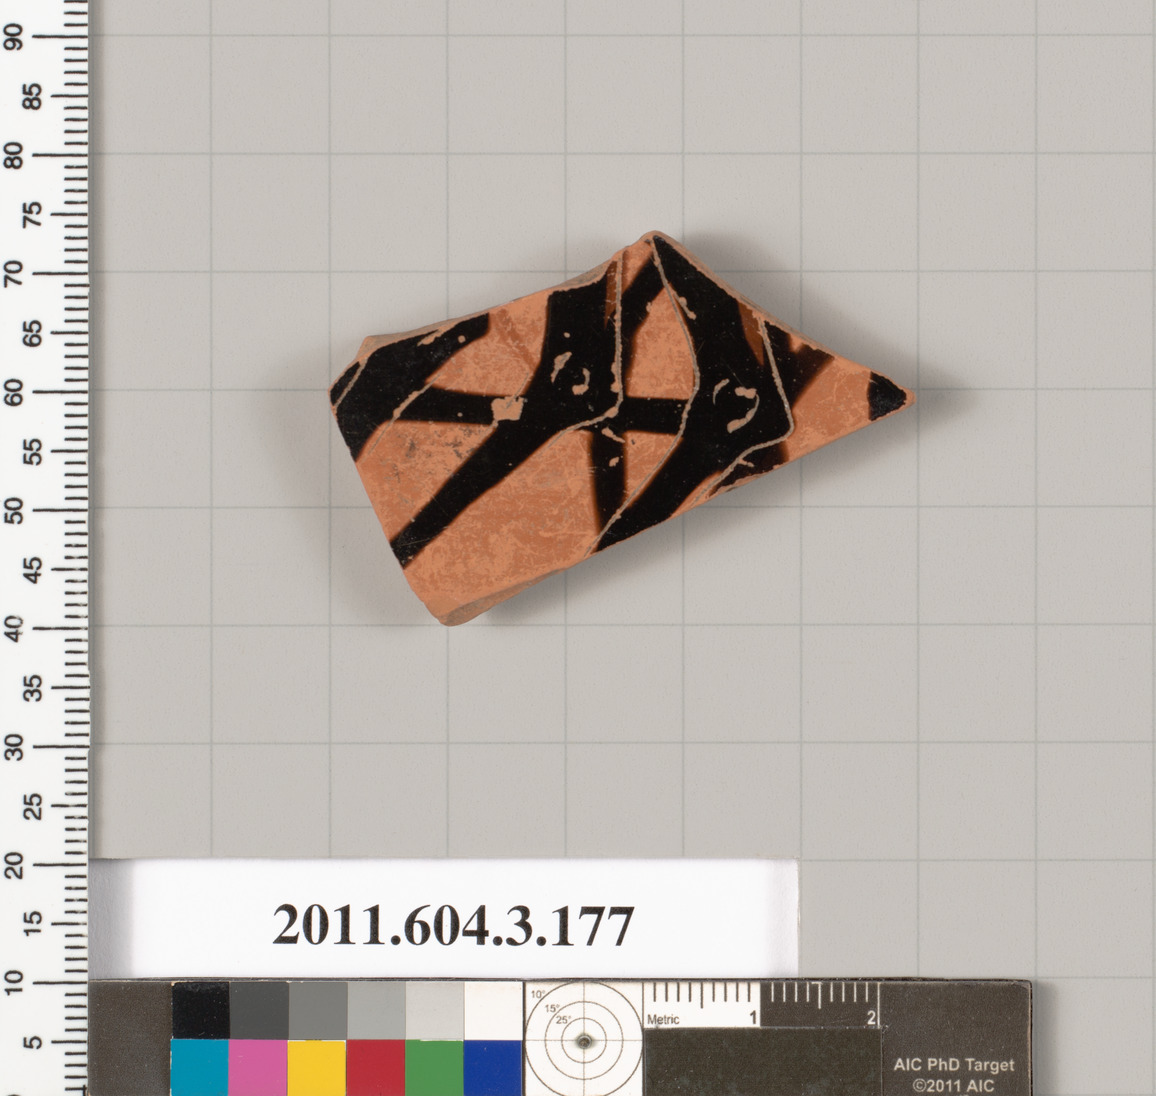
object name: amphora fragment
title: Terracotta fragment of an amphora (jar)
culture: greek, attic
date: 525-501 BCE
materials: terracotta